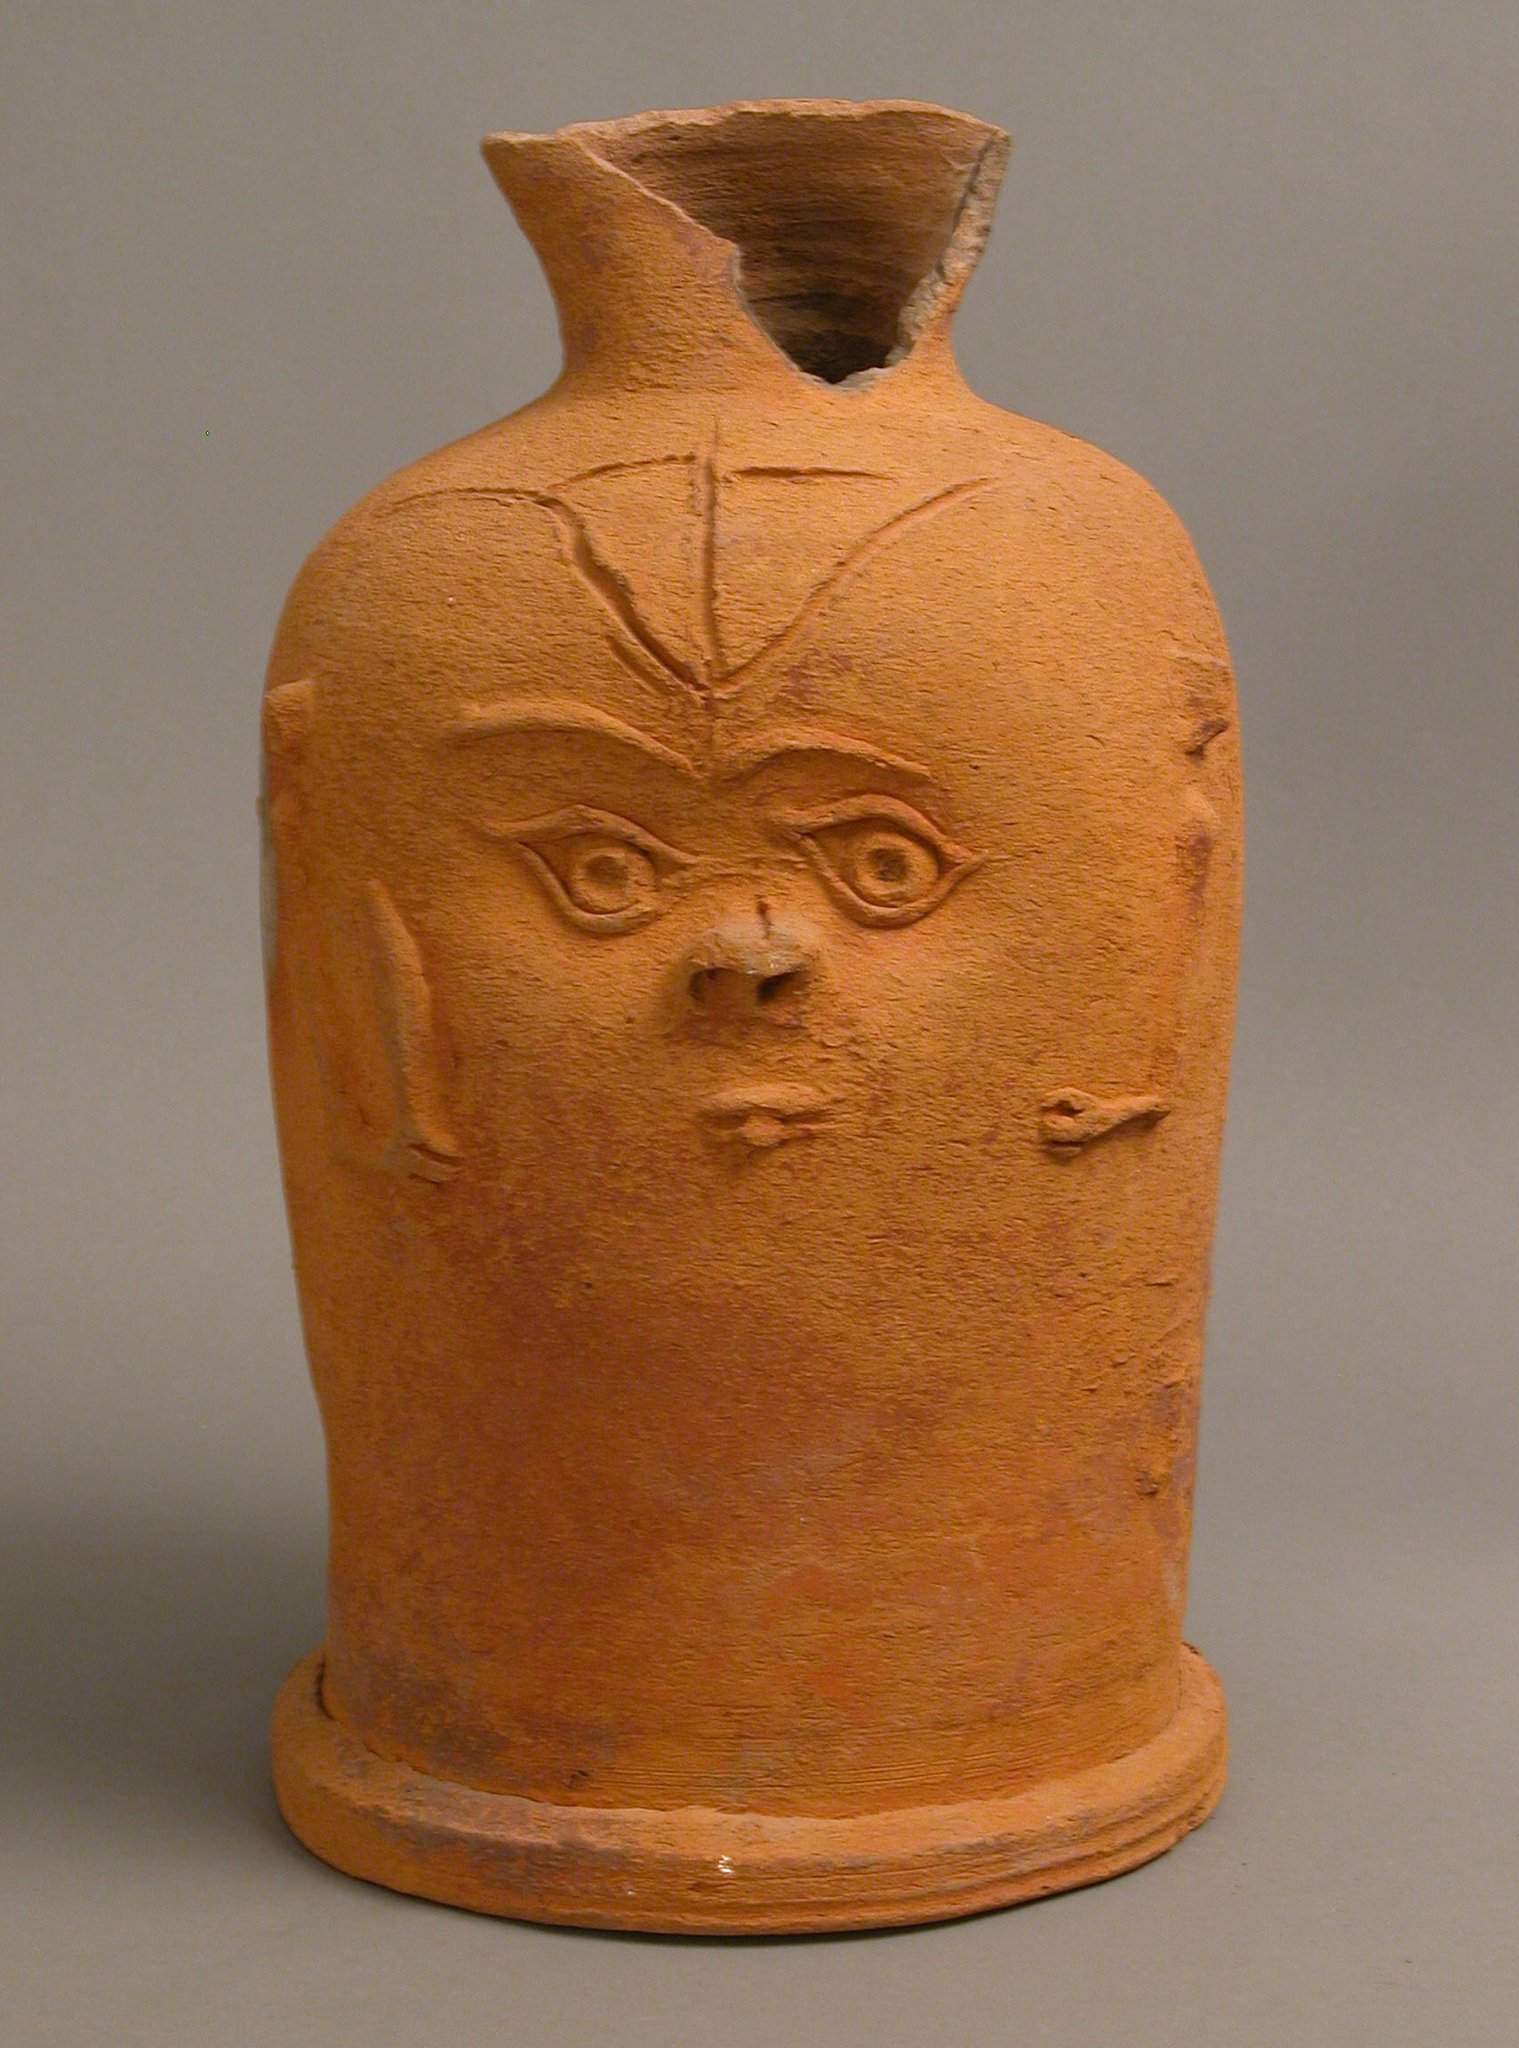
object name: jar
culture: coptic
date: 301-700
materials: earthenware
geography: egypt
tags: faces